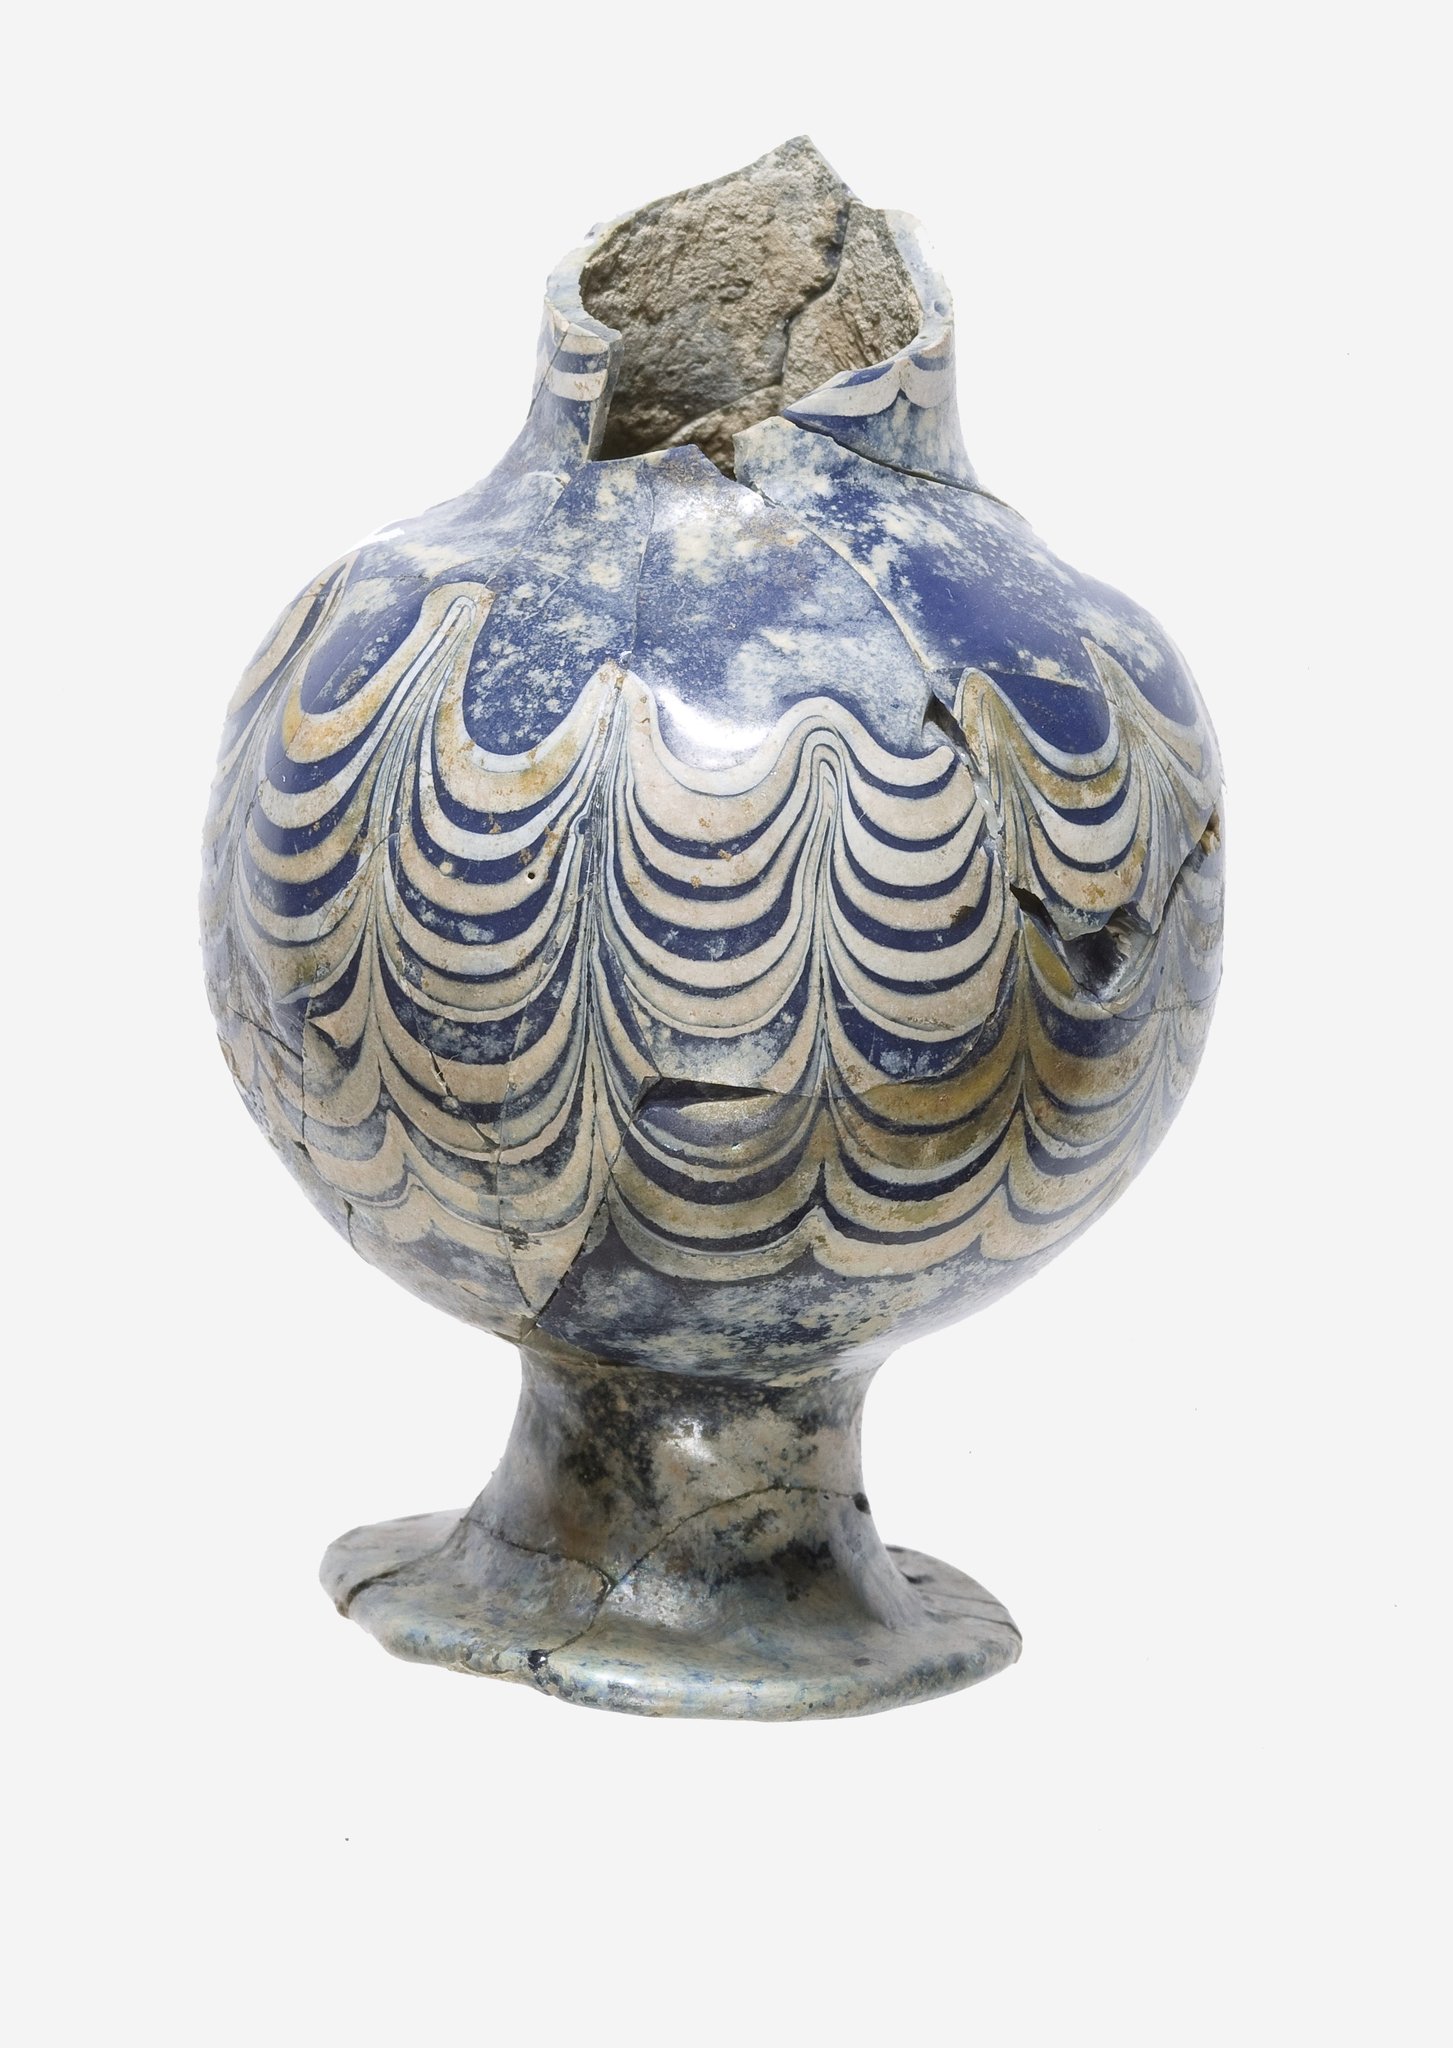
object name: vase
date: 1390-1352 BCE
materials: glass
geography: egypt